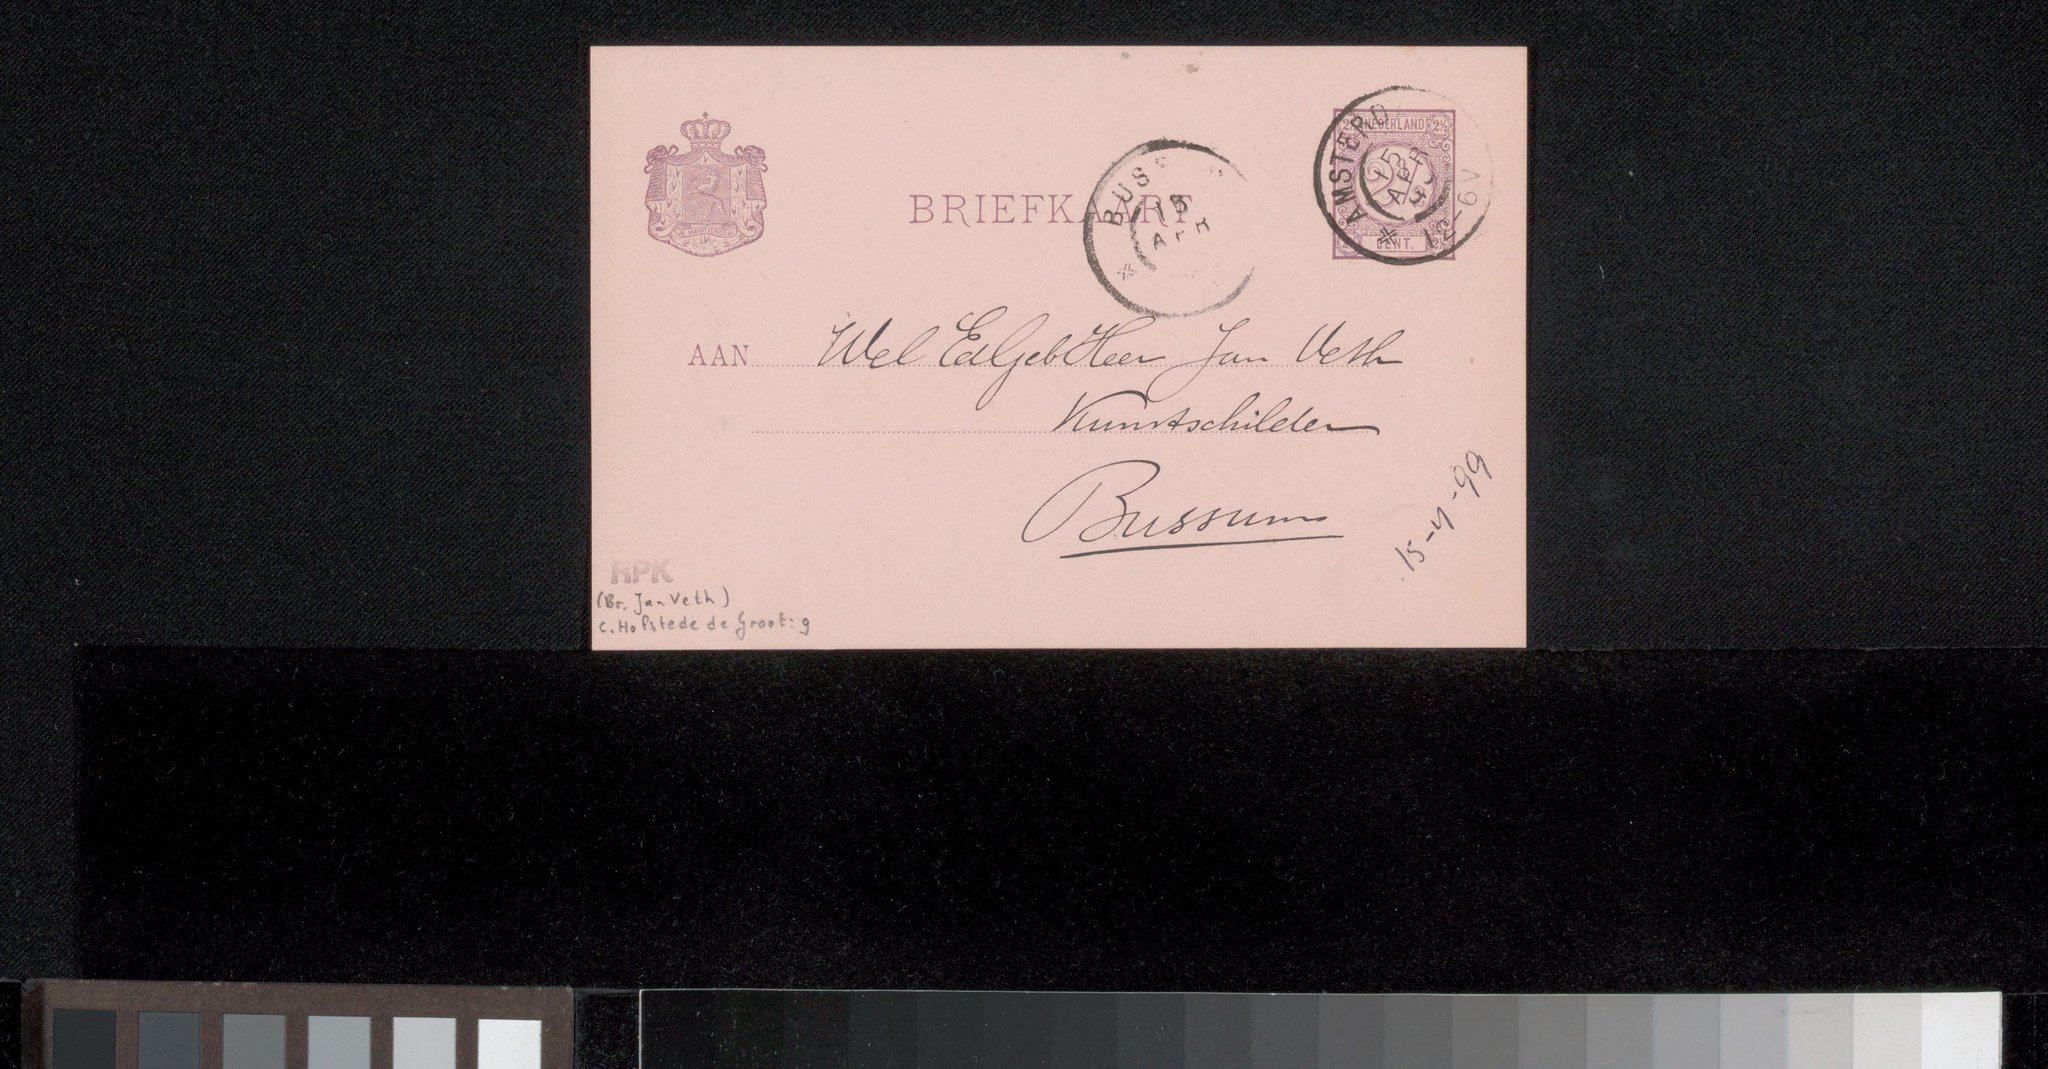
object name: postcard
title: Briefkaart aan Jan Veth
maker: cornelis hofstede de groot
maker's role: kunsthistoricus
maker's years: 1863-1940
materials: cardboard, ink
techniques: pen, writing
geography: amsterdam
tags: dordrecht, amsterdam, painter, draughtsman, designer, jan veth, publisher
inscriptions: collector's mark: ‘RPK’